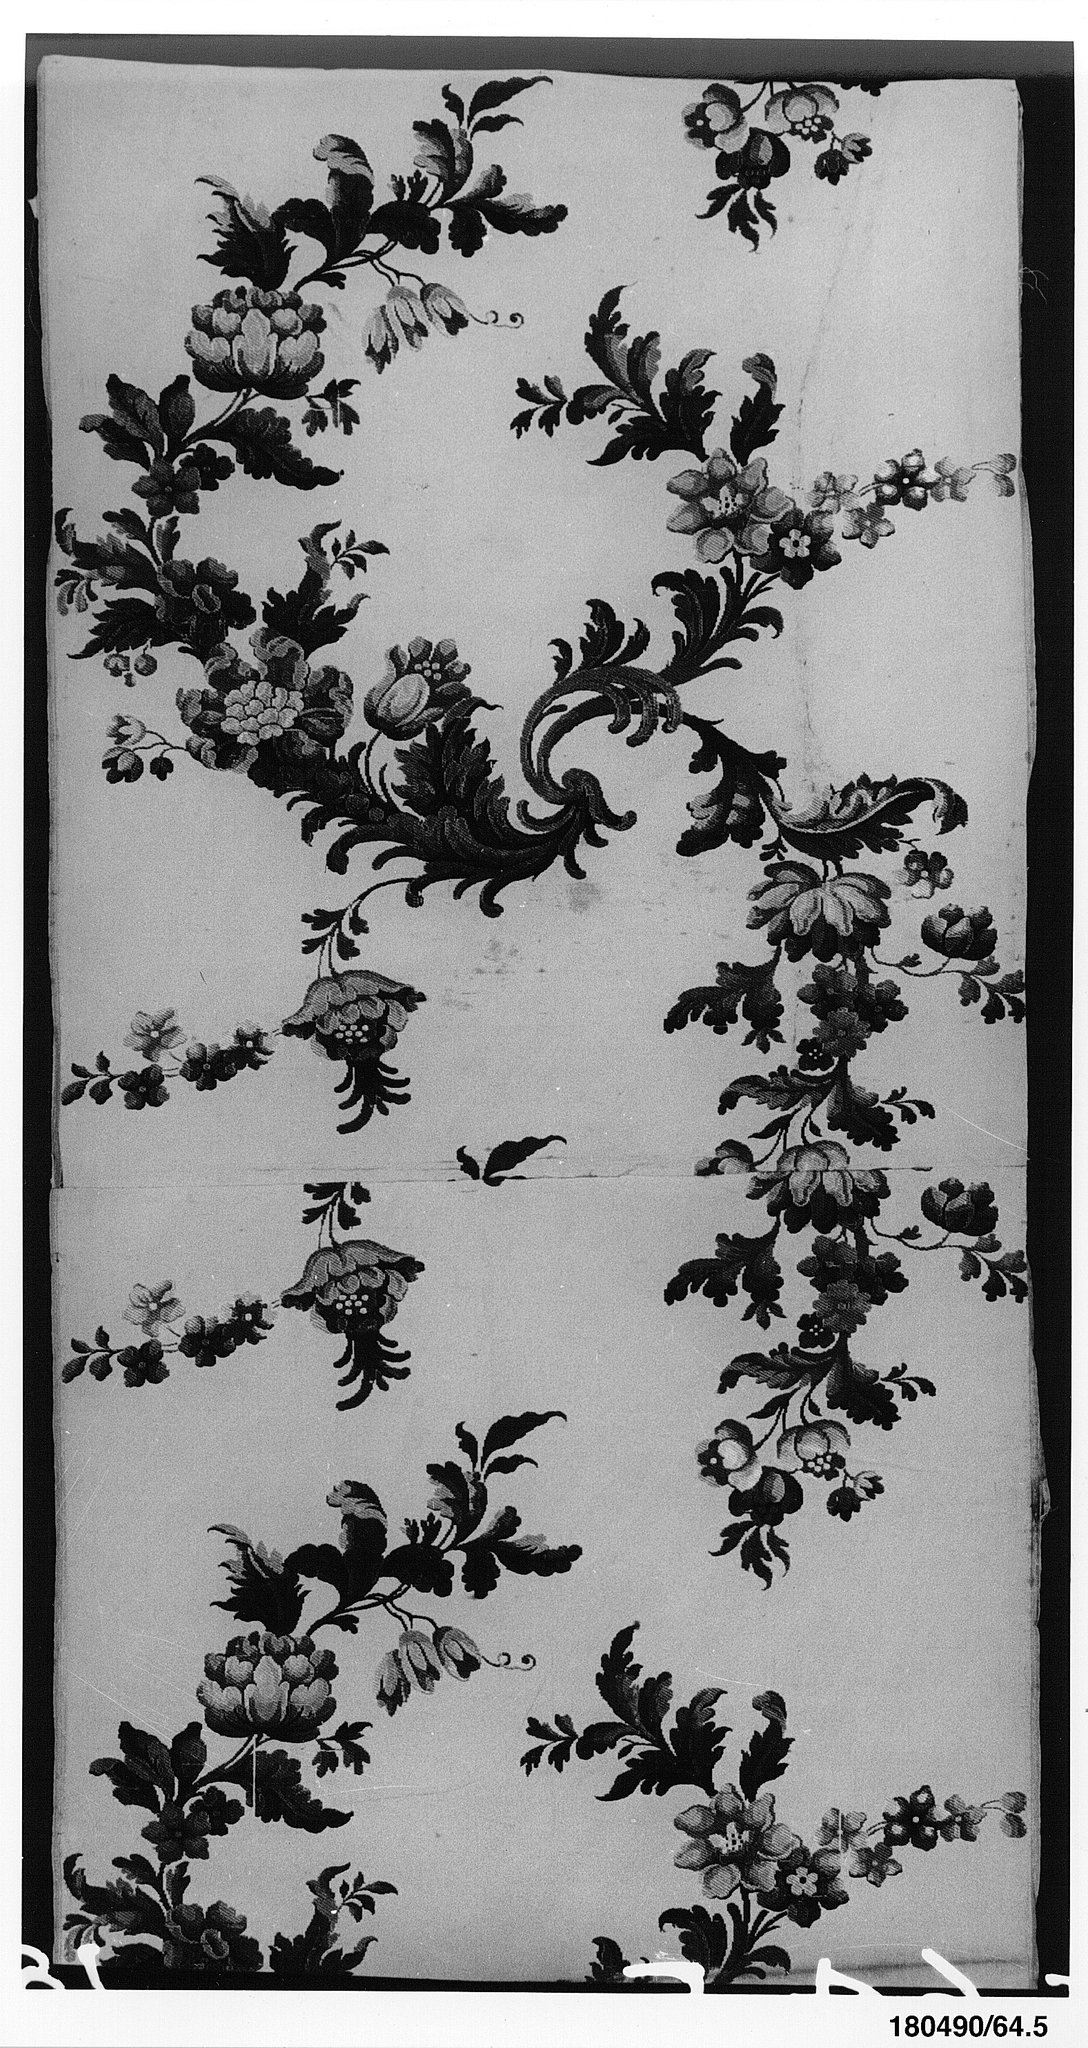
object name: piece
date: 1740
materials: silk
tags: flowers,leaves